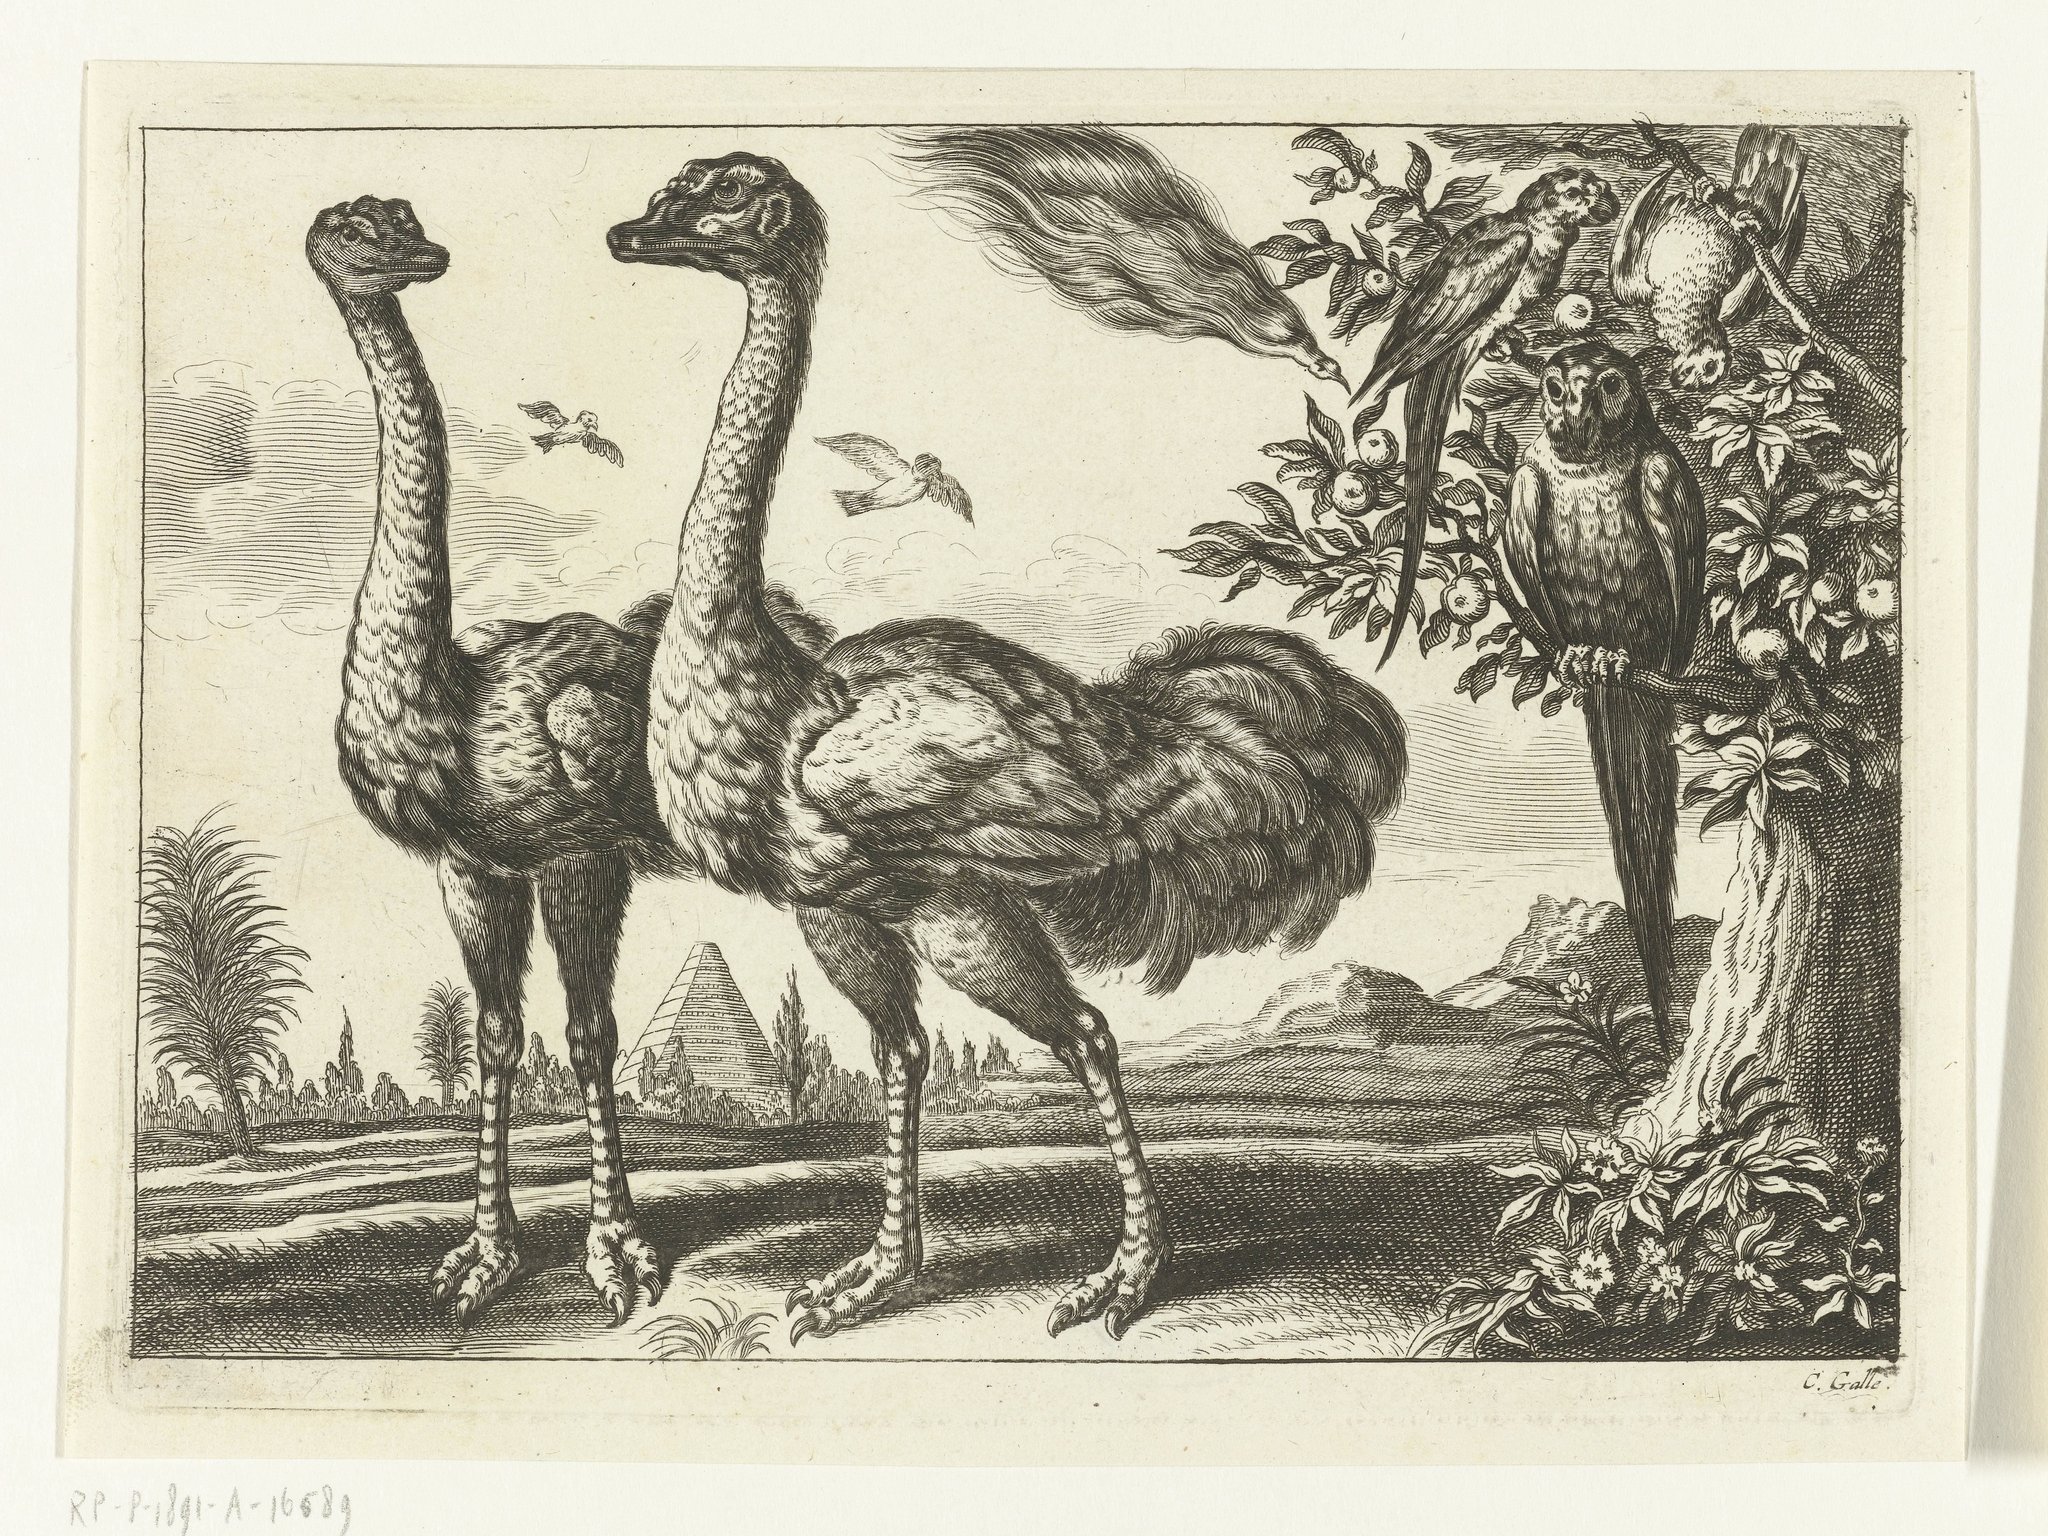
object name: print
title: Verschillende vogels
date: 1654-1678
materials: paper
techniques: engraving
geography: antwerp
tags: walker and runner birds: ostrich, birds, egyptian pyramids (wonder of the world)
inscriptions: collector's mark: Lugt 2228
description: Prent maakt deel uit van de zeventiendelige serie met voorstellingen van verschillende vogels: "Diversarum avium species".